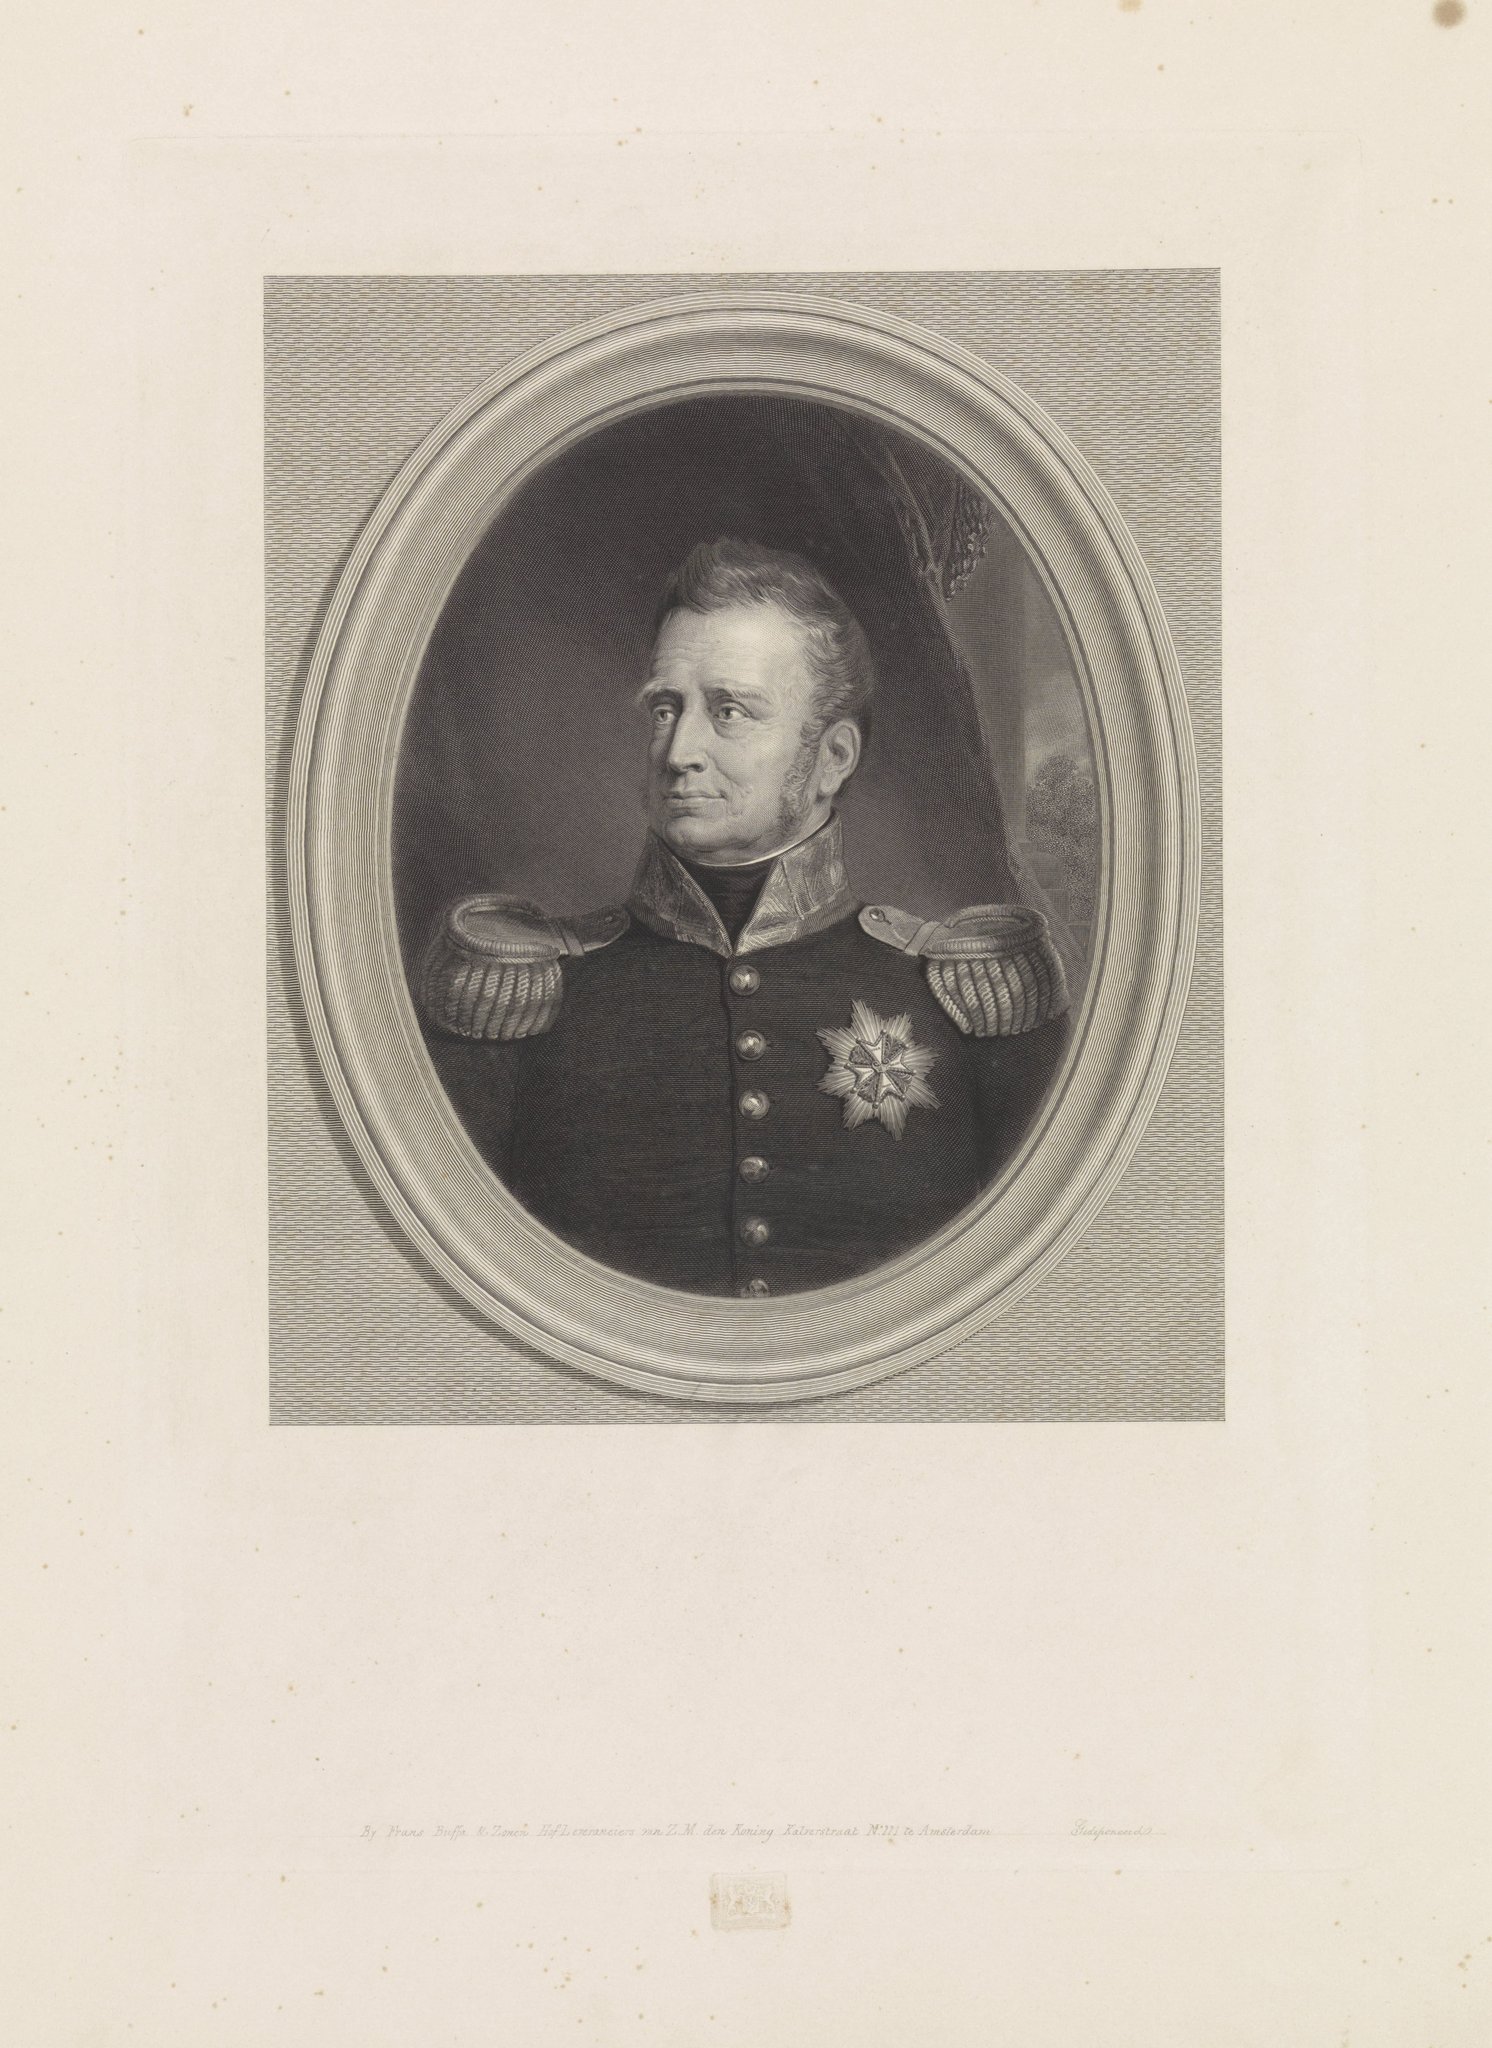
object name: print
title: Portret van Willem I Frederik, koning der Nederlanden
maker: benoit taurel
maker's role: draughtsman, print maker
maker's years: 1794-1859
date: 1831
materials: paper, pencil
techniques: engraving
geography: amsterdam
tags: the hague, berlin, william i of the netherlands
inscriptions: collector's mark: Lugt 12, caption: ‘By Frans Buffa & Zonen HofLeveranciers van Z.M. den Koning Kalverstraat No. 221 te Amsterdam Gedeponeerd’, check stamp: ‘François Buffa & Fils’